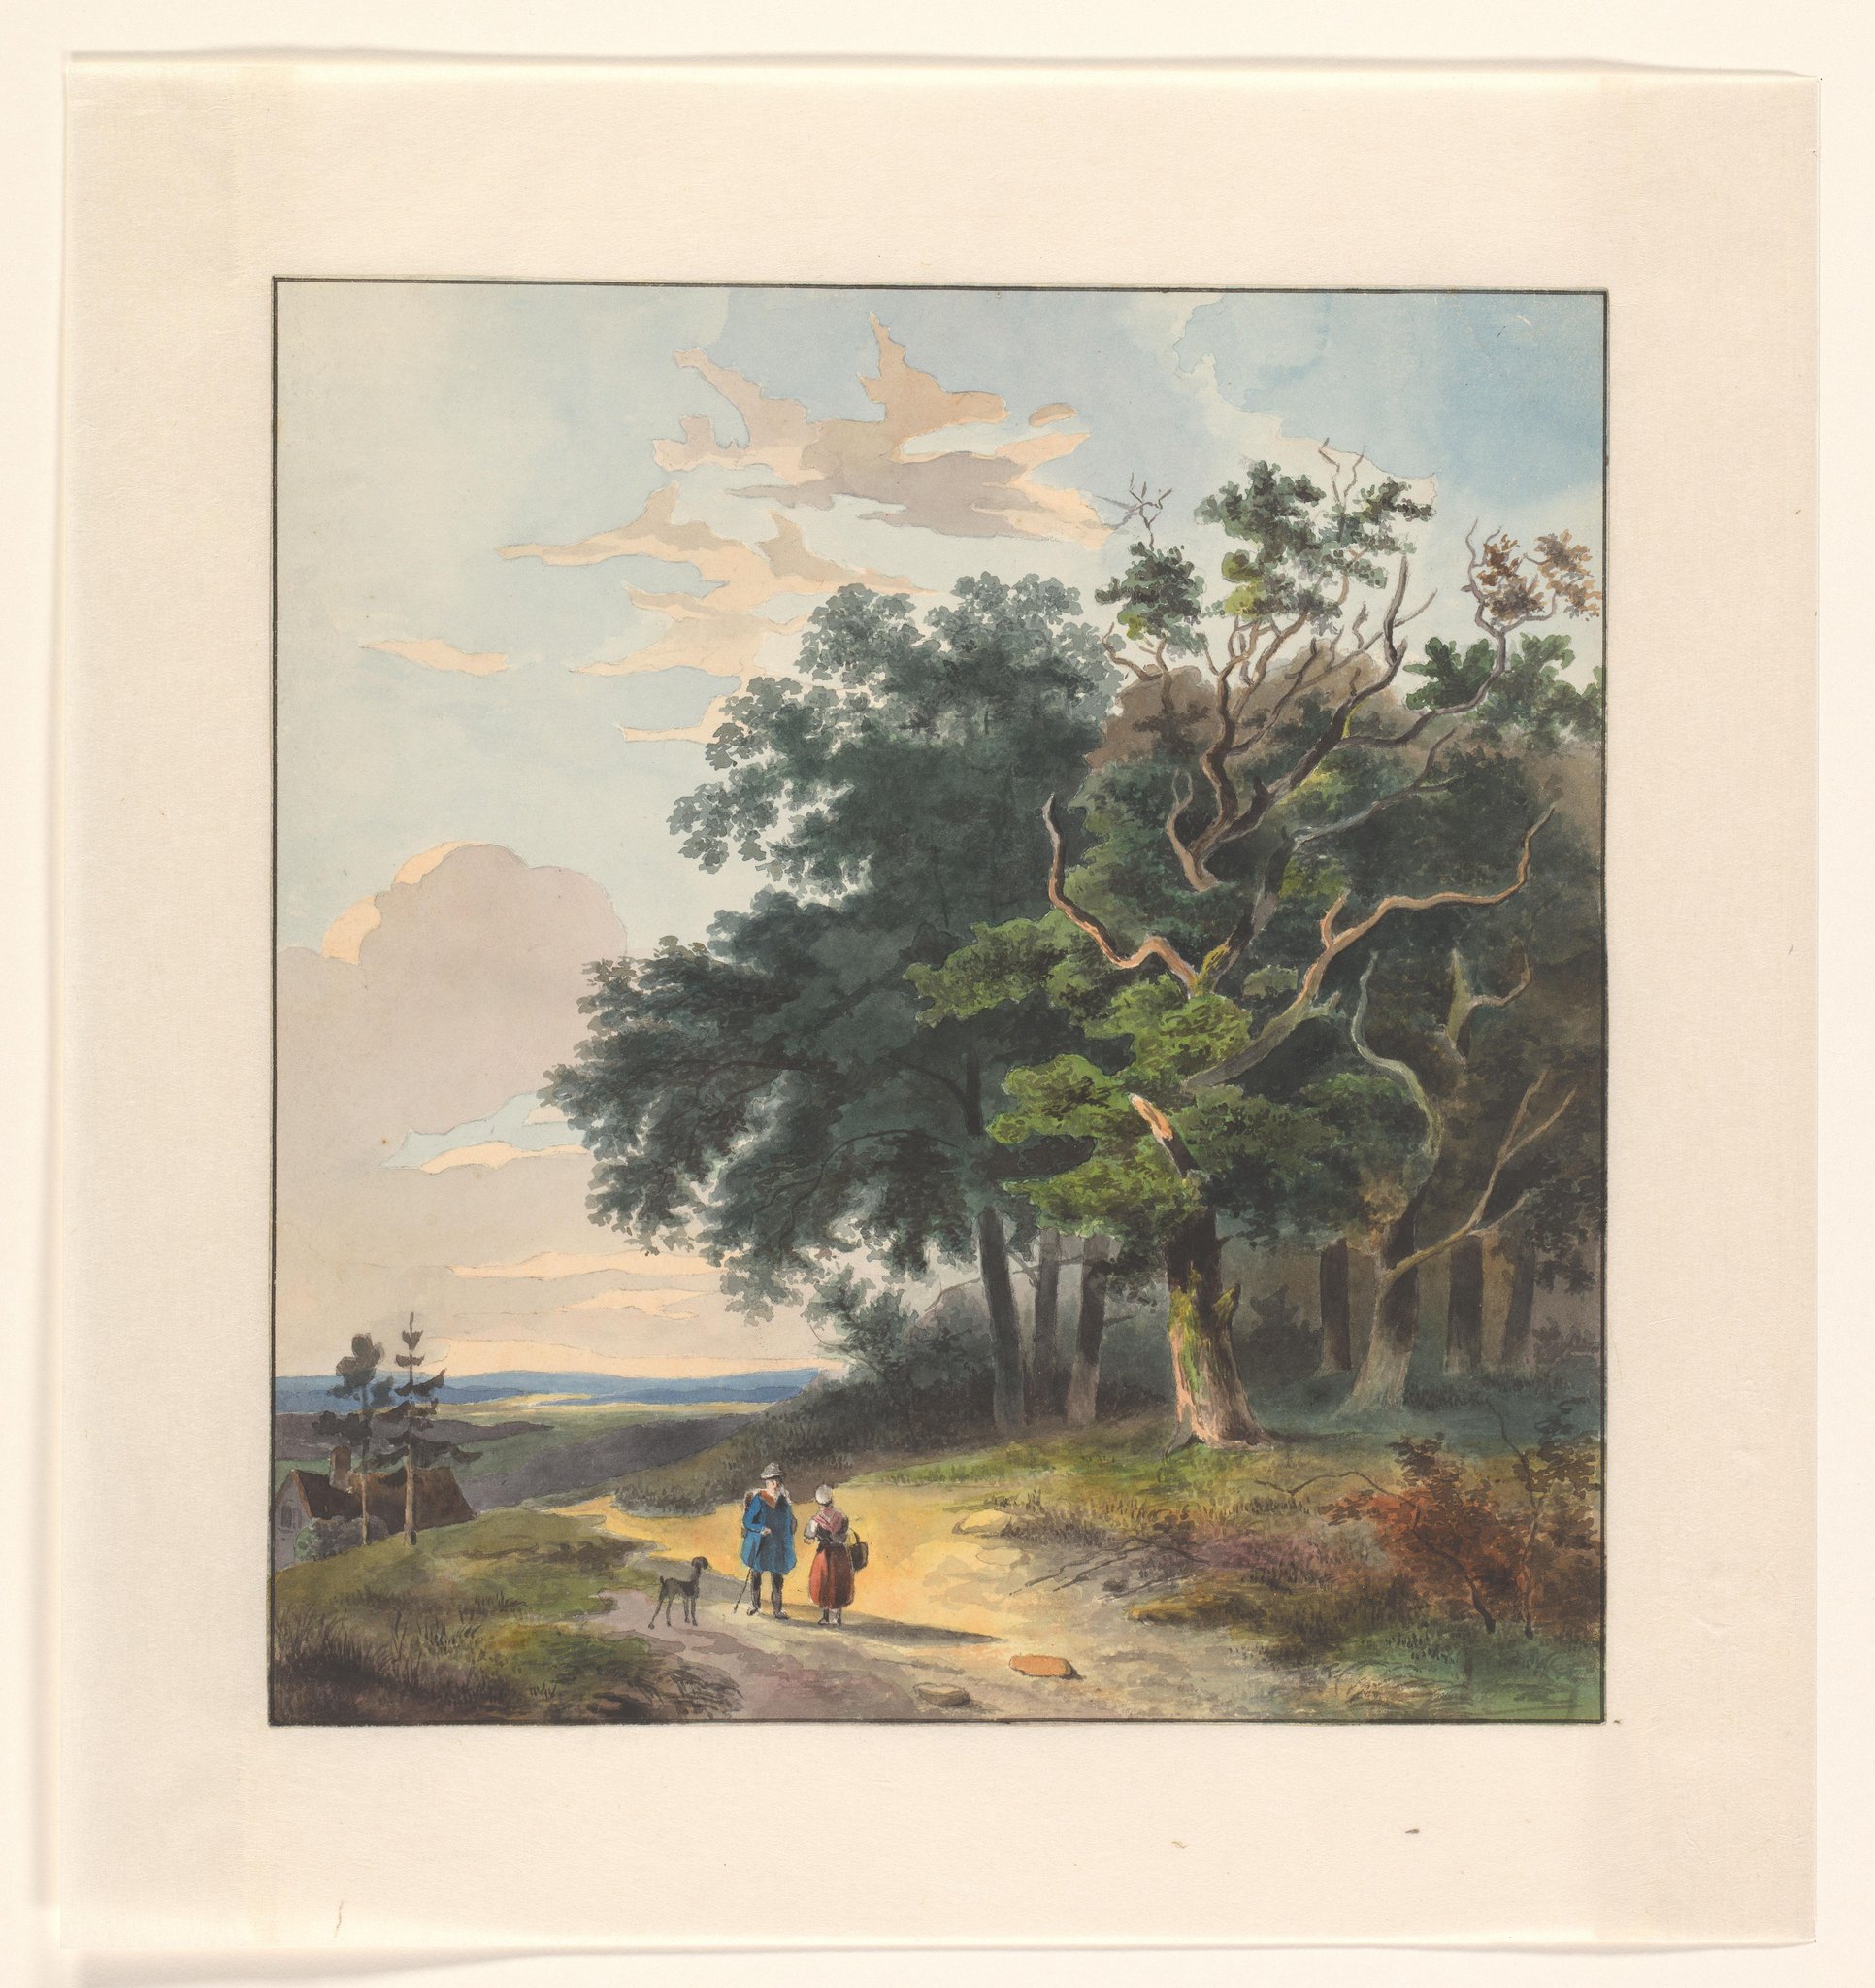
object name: drawing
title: Twee figuren op een landweg langs een bosrand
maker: johannes van reijn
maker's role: draughtsman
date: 1800-1900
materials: paper, pencil, watercolor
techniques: brush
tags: forest, wood (+ landscape with figures, staffage)